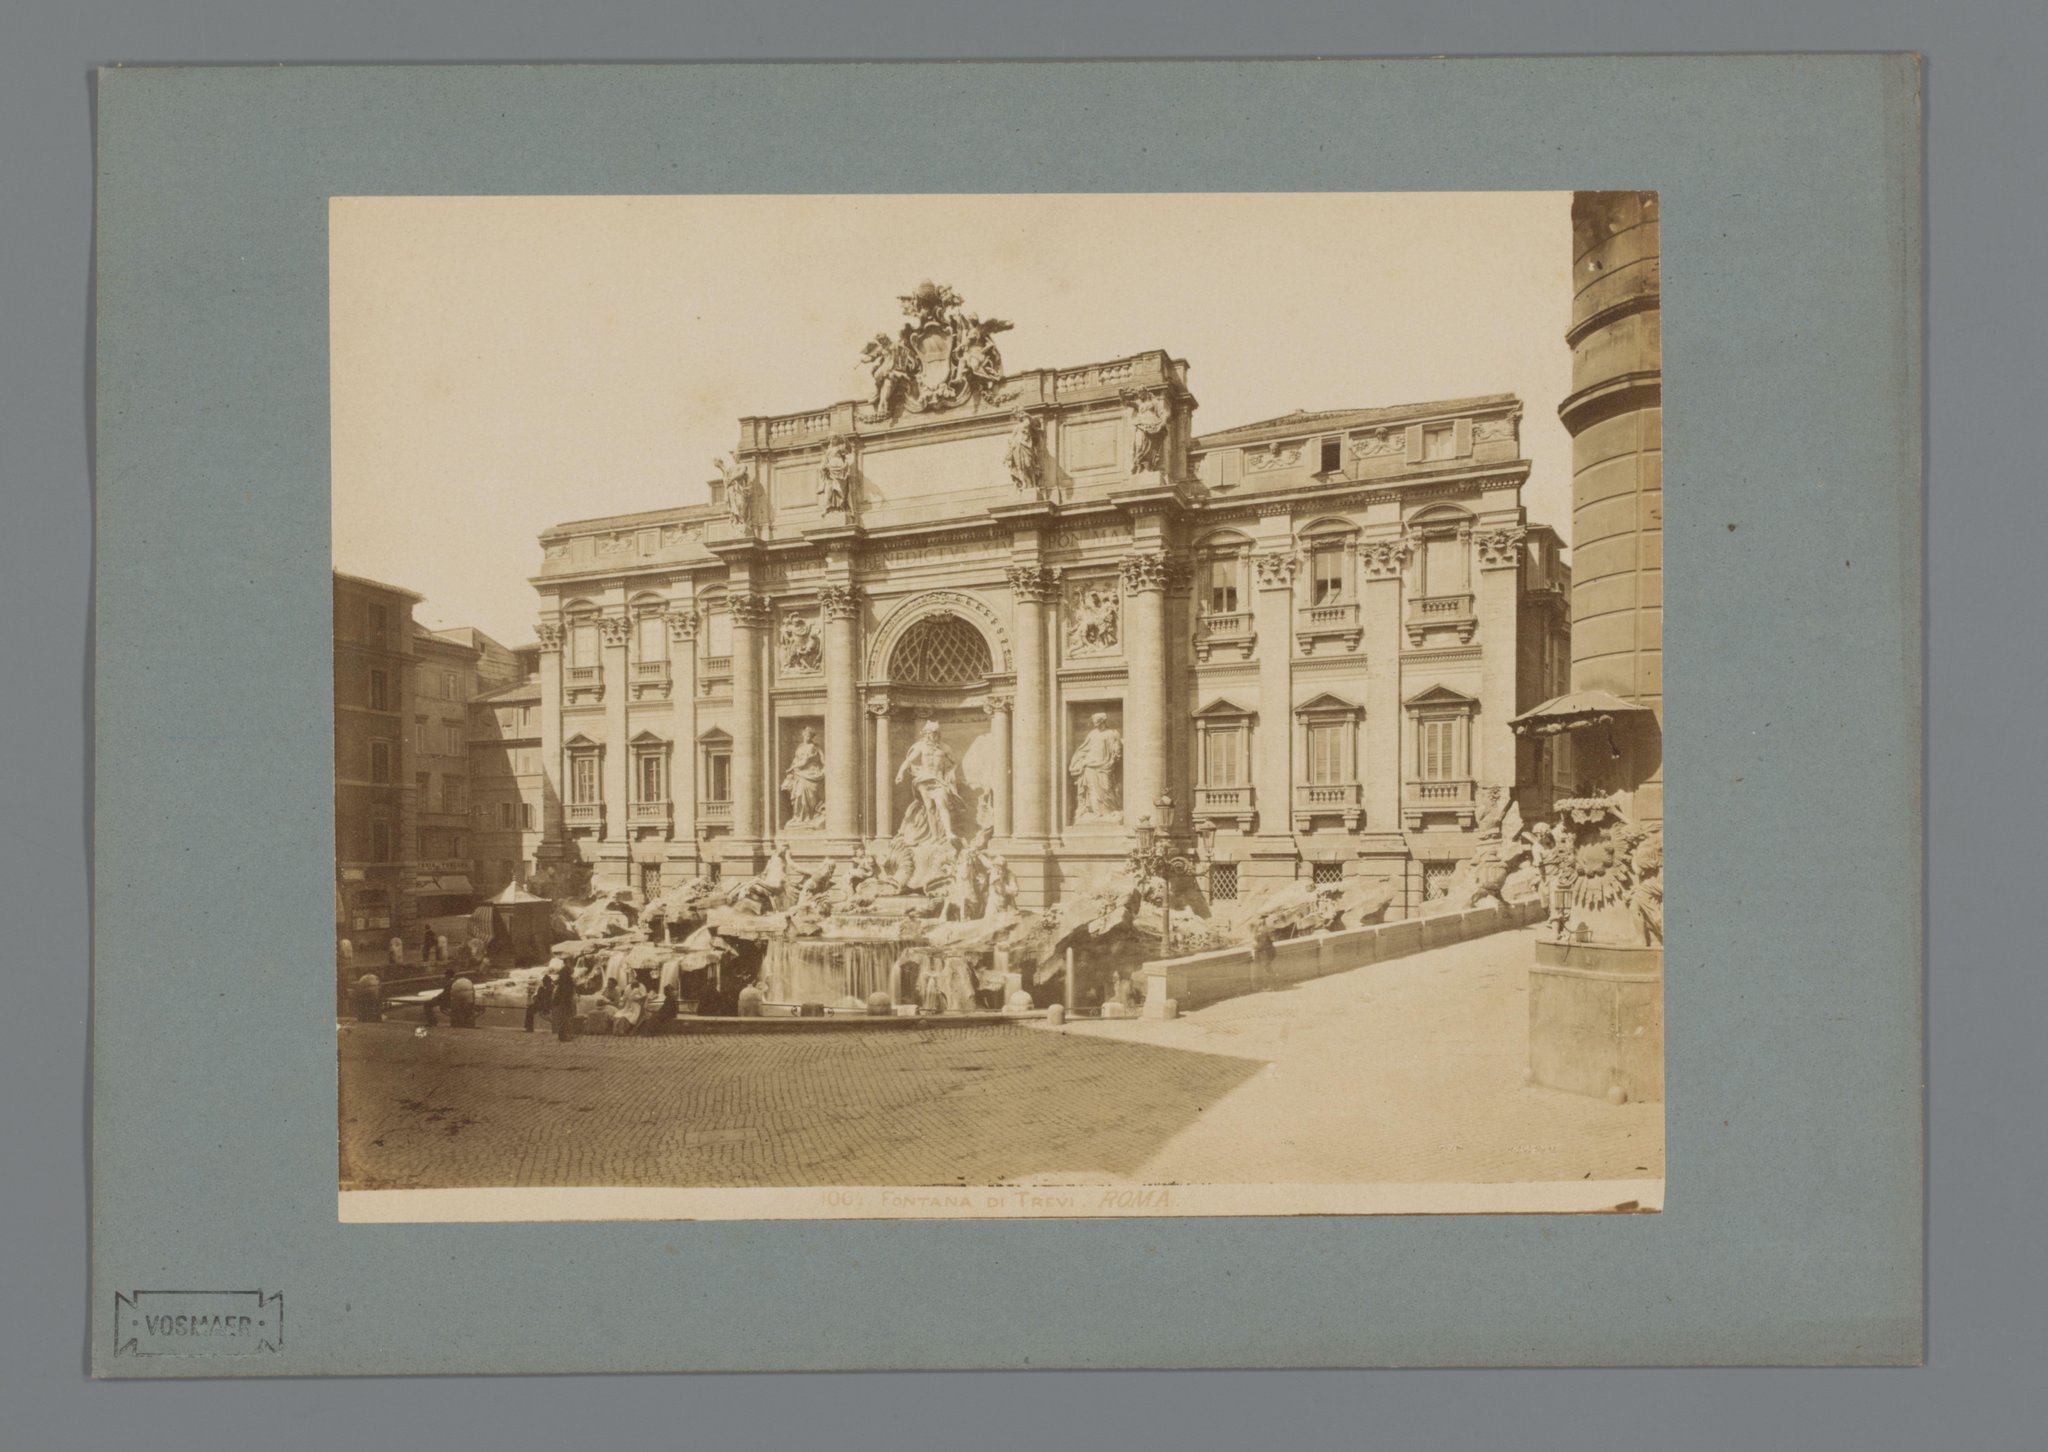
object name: photograph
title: Fontana di Trevi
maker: Anonymous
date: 1851-1890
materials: cardboard, paper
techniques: albumen print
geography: rome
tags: ornamental fountain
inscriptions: number: ‘1064’, collector's mark: ‘VOSMAER’